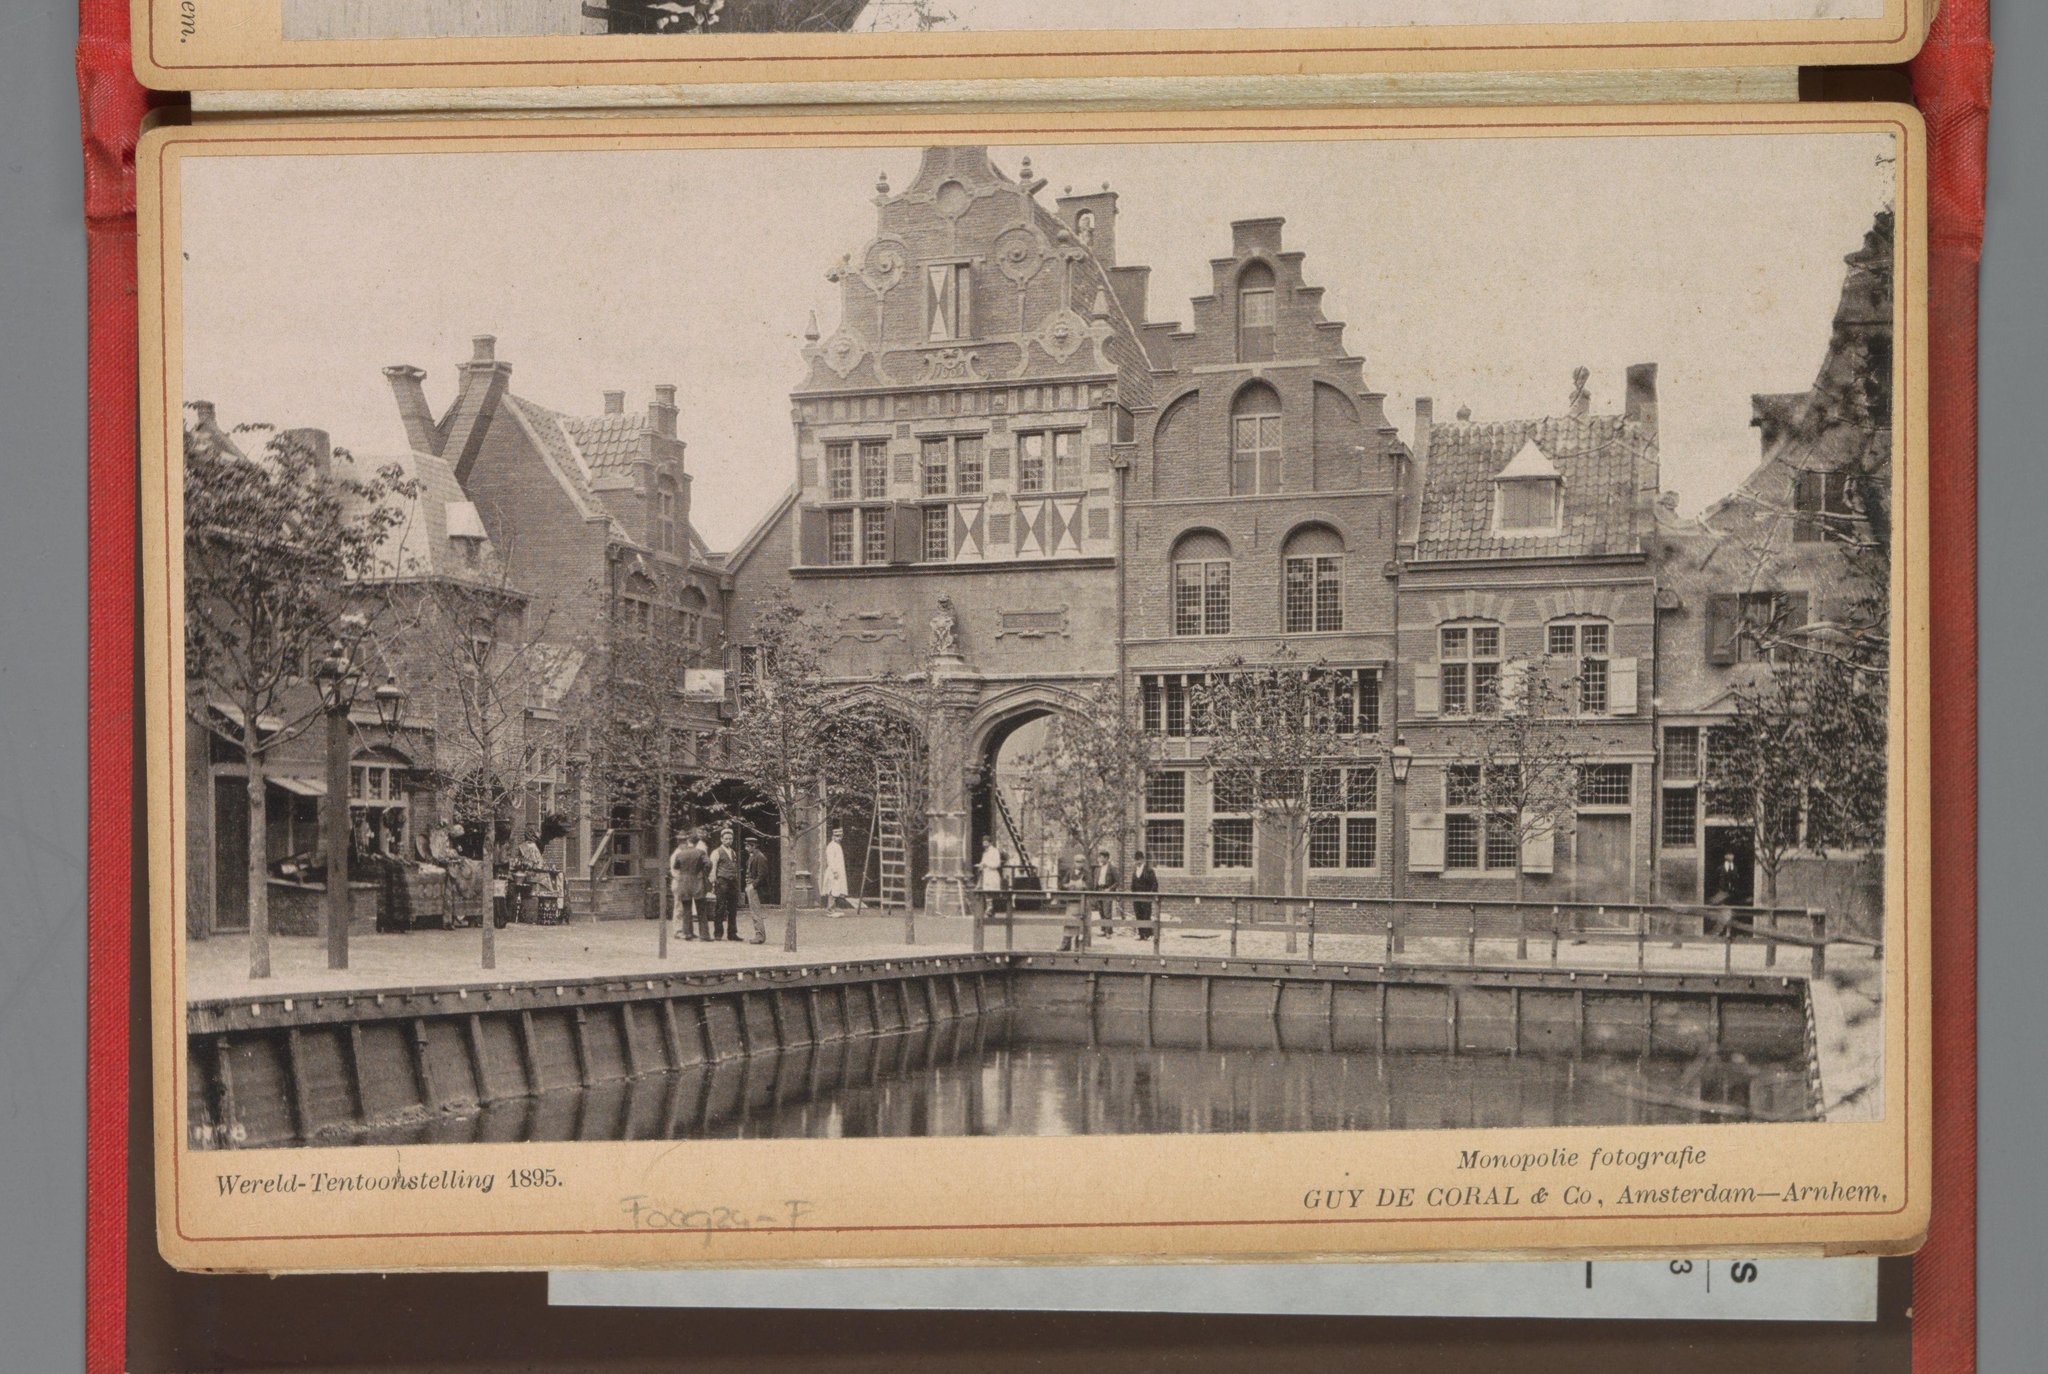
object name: photograph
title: Wereld-Tentoonstelling 1895.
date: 1895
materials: cardboard, paper, ink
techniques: photograph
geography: amsterdam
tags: façade (of house or building), prospect of city, town panorama, silhouette of city, temporary exhibition, 'salon', amsterdam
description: Onderdeel van Fotoalbum met opnames van de Wereldtentoonstelling voor het Hotel- en Reiswezen op het Museumplein in 1895.